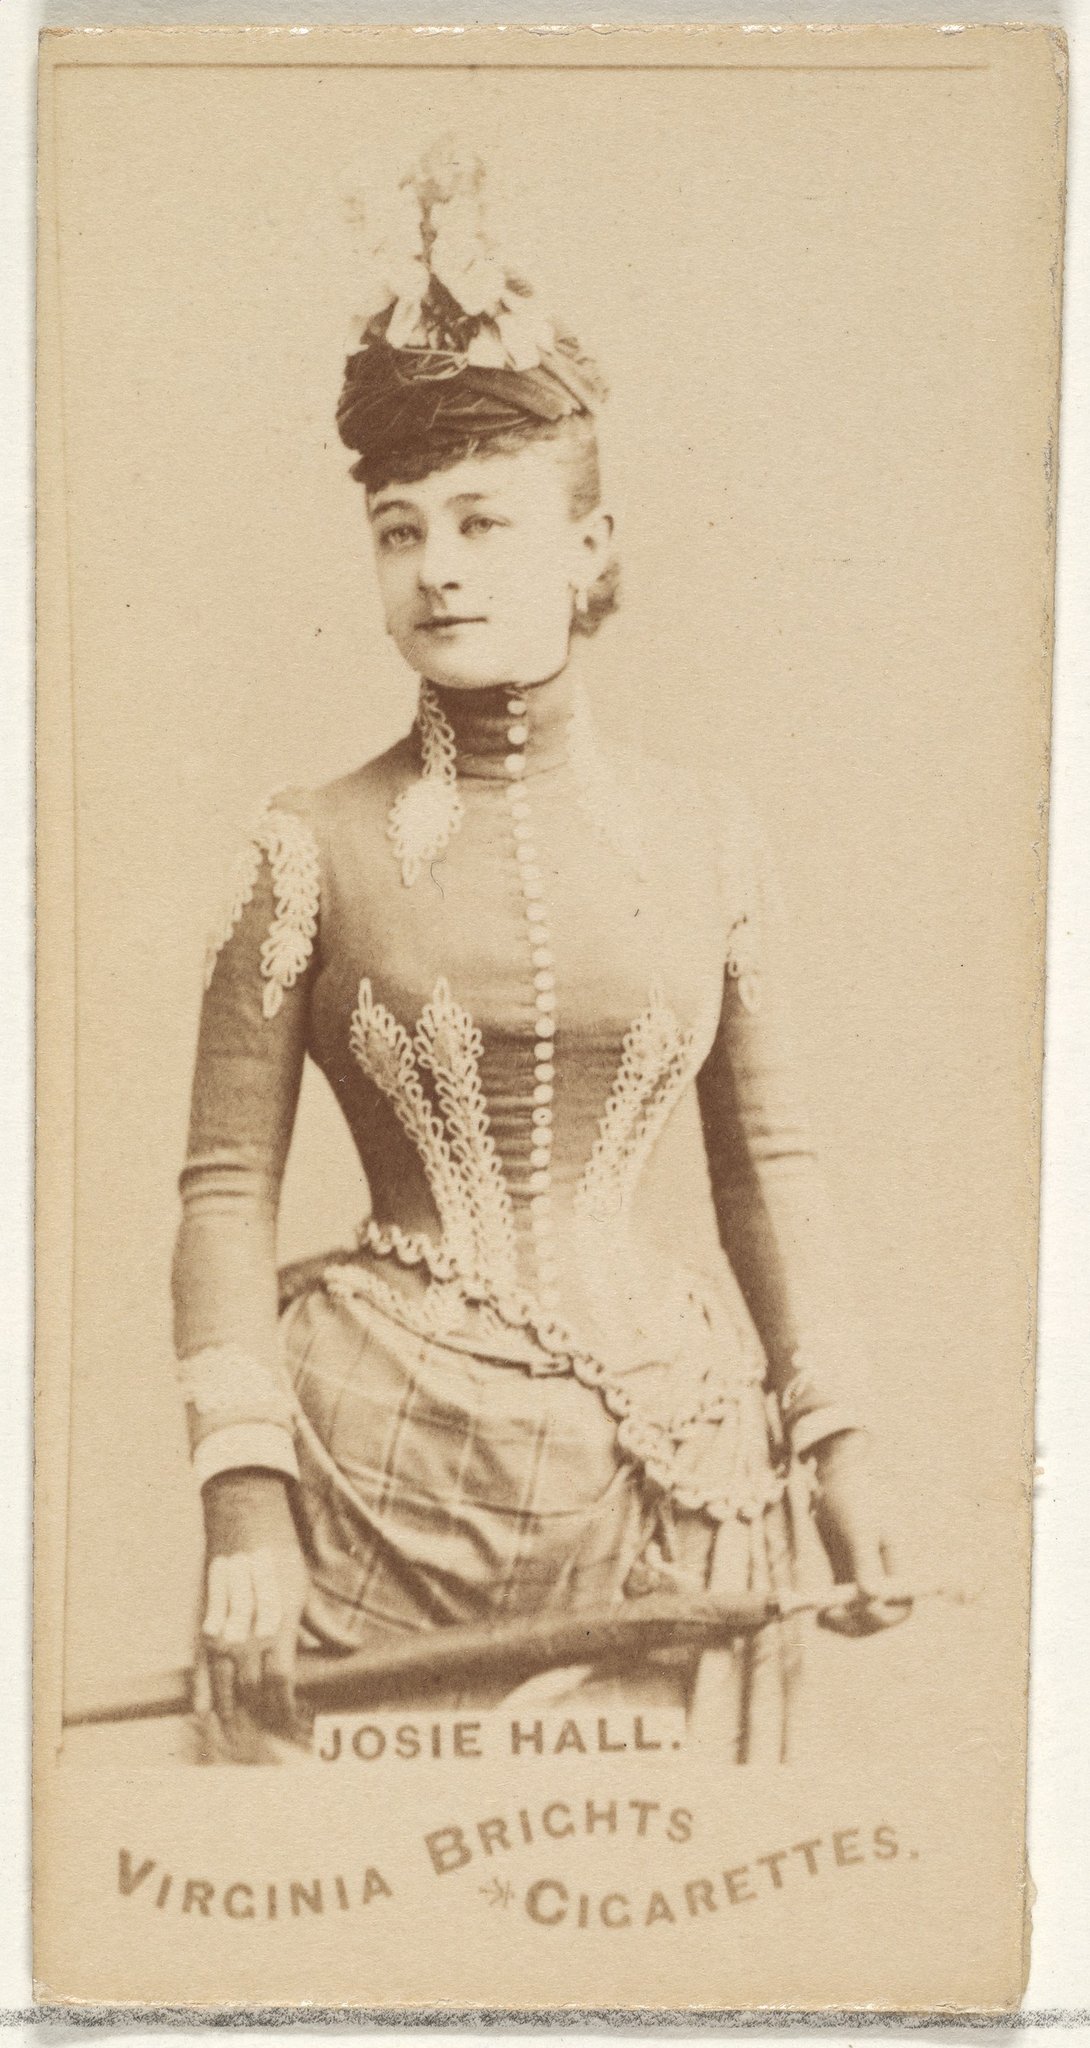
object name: photograph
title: Josie Hall, from the Actors and Actresses series (N45, Type 1) for Virginia Brights Cigarettes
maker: allen & ginter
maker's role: publisher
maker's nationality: american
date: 1888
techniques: albumen silver print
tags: portraits,women,actresses